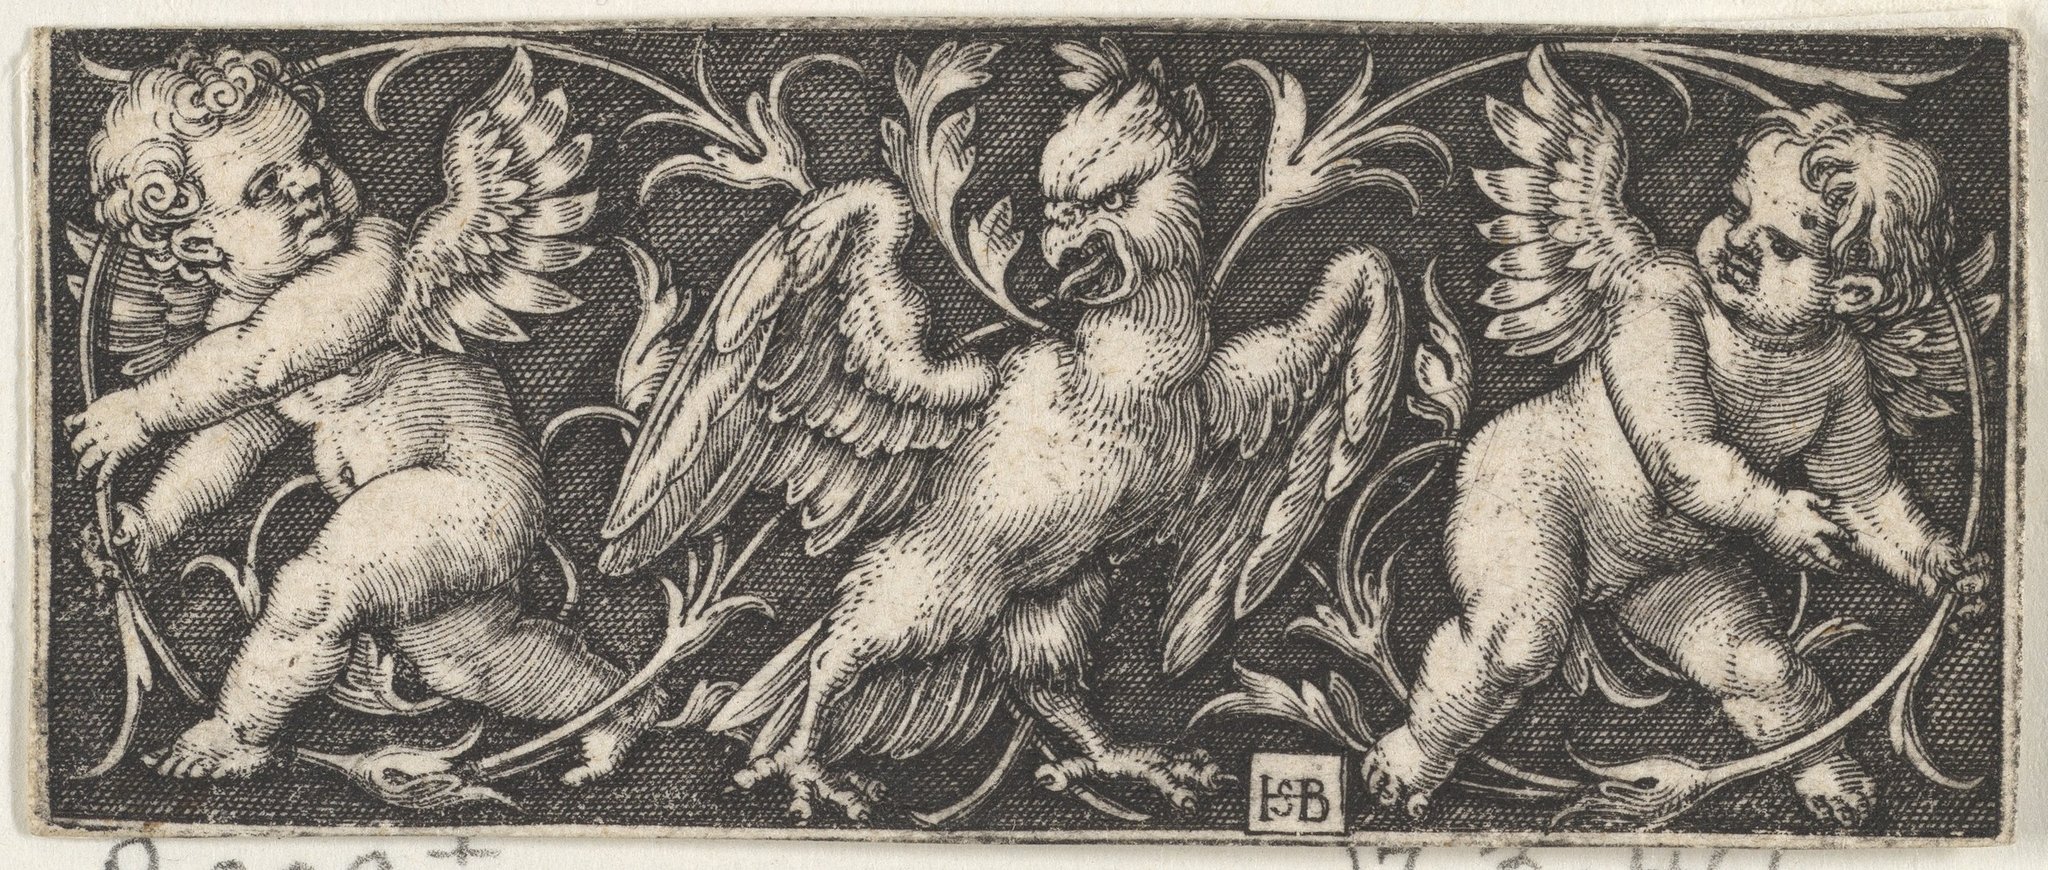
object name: print ornament architecture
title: Horizontal Panel with an Eagle Flanked by Two Genii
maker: sebald beham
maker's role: artist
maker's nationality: german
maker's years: 1500-1550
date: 1544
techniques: engraving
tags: eagles,putti